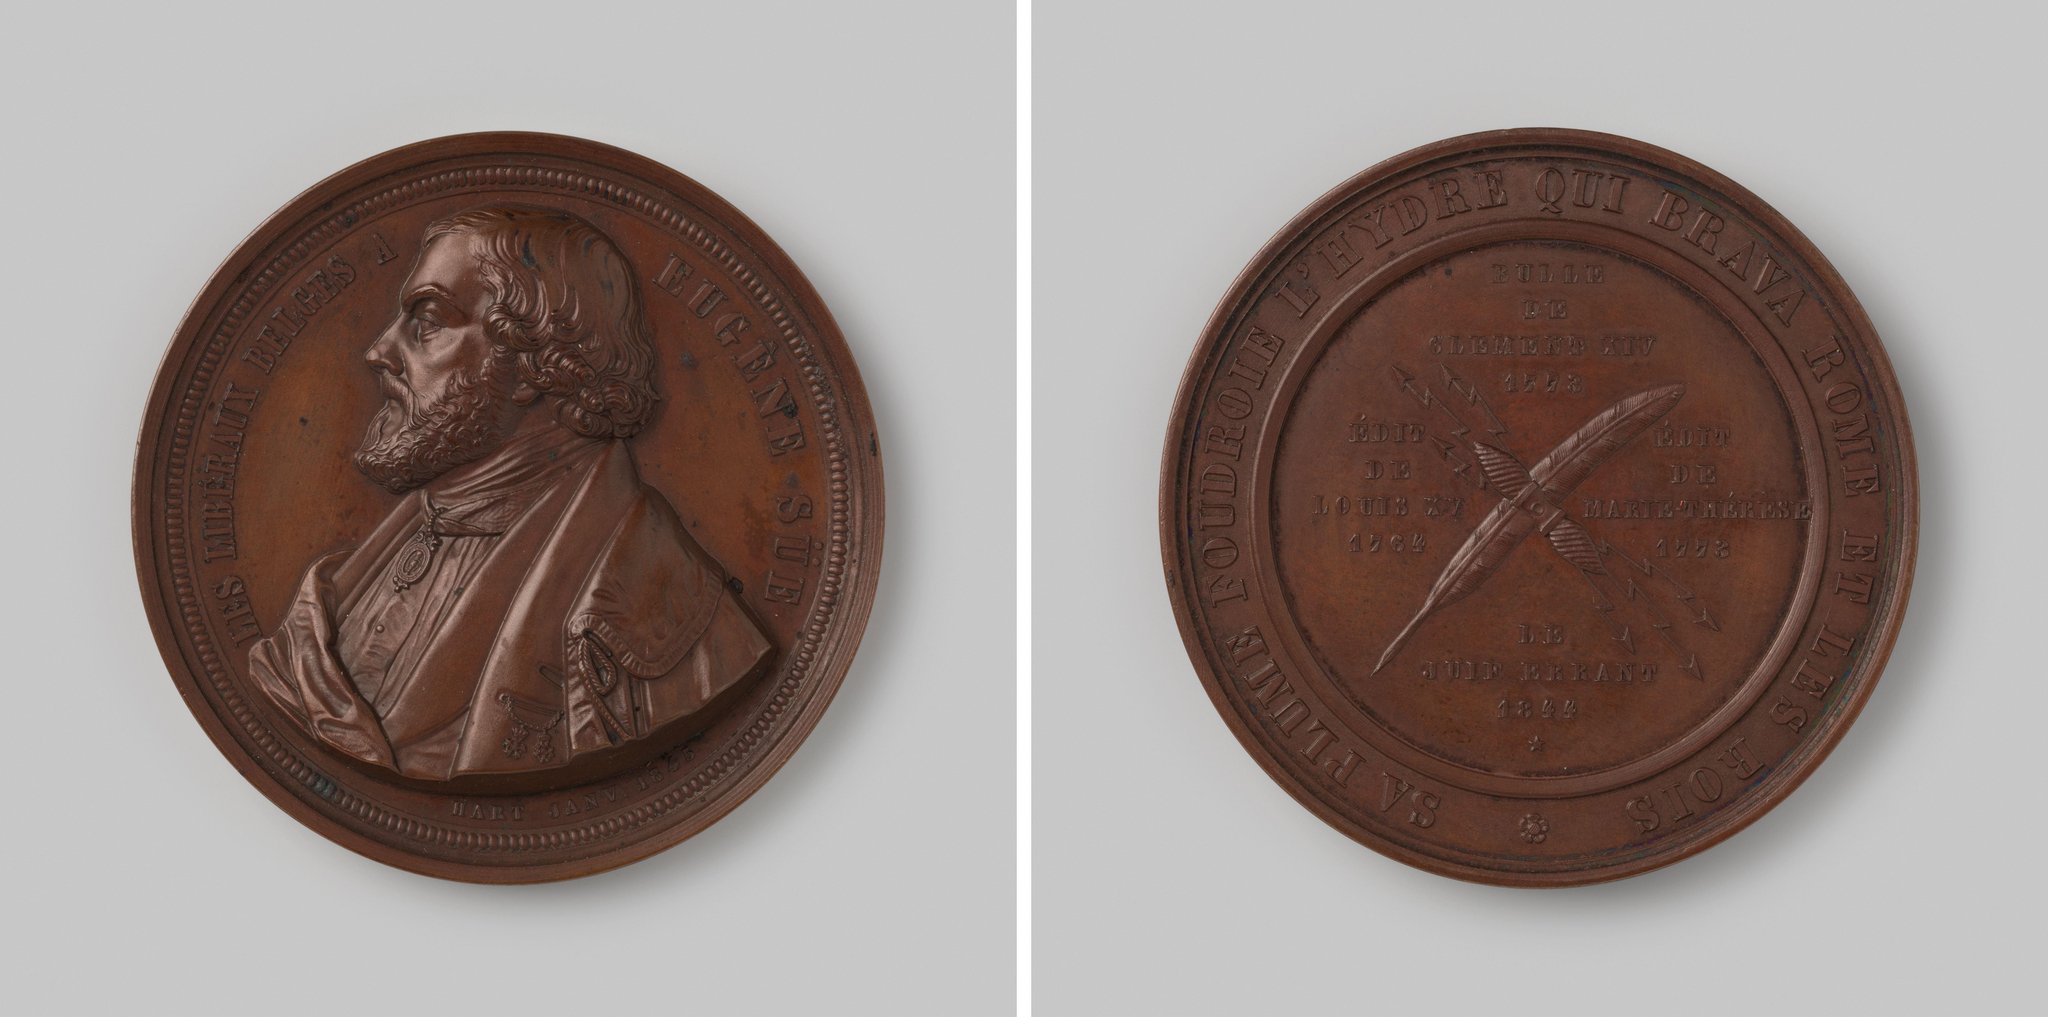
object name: history medal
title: Eugène Süe (1845)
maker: hart (stempelsnijder)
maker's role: die cutter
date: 1845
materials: bronze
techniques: striking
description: Bronzen penning, op de voorzijde het borstbeeld van Süe naar links met omschrift, op de keerzijde een gekruiste ganzeveer en bliksemschicht tussen vier opschriften, met omschrift